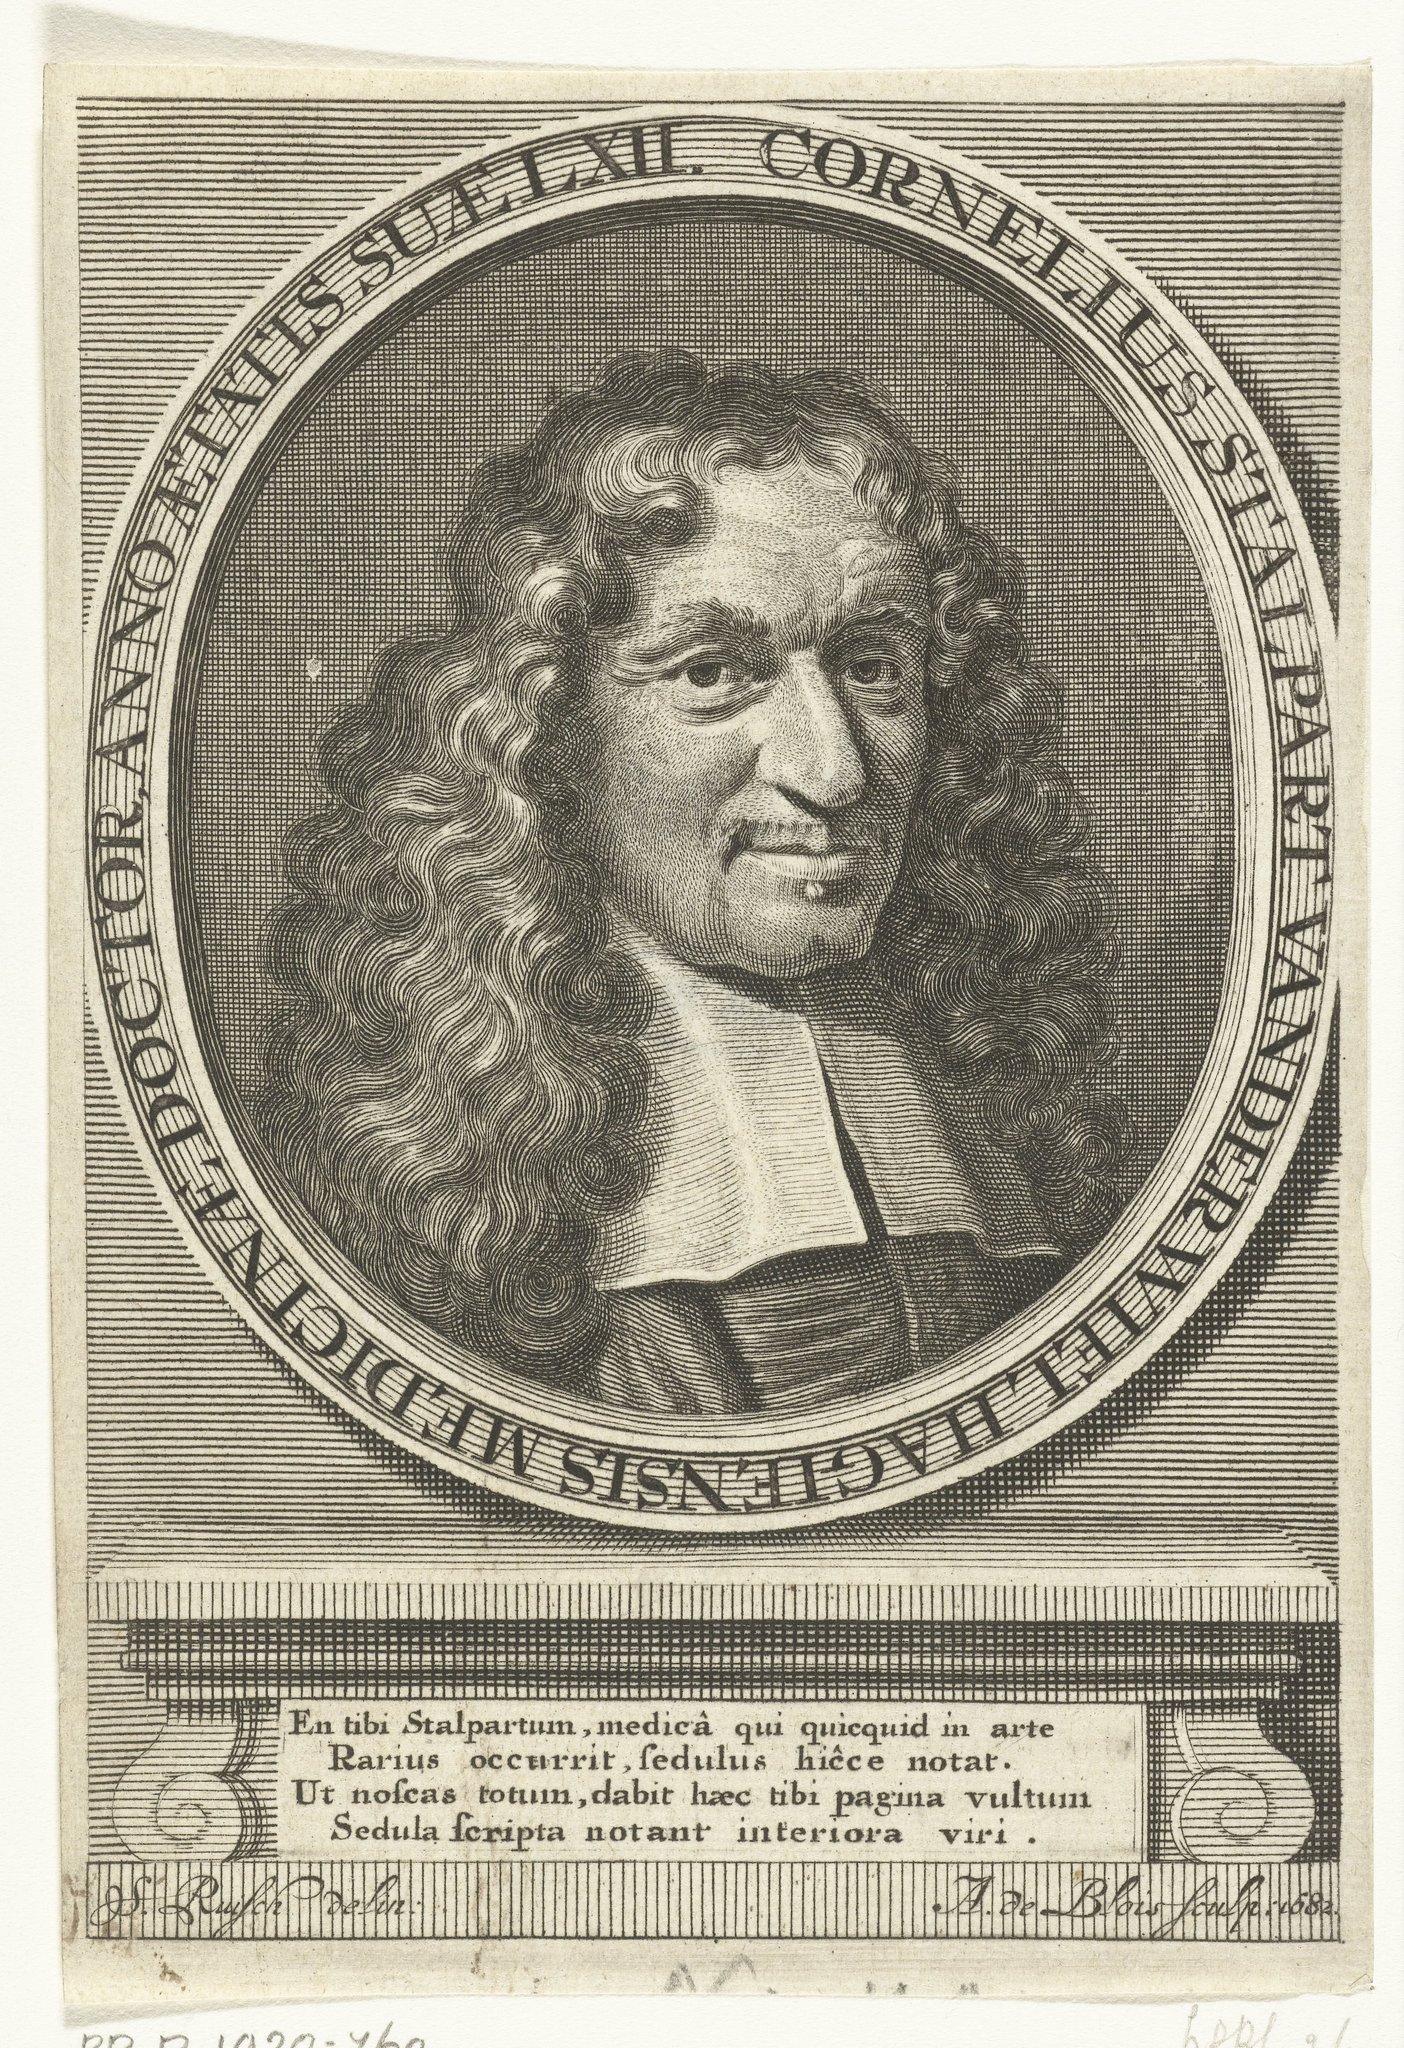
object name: print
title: Cornelius Stalpart van der Wiel Hagiensis medicinae doctor anno aetatis suae LXII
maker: abraham de blois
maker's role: print maker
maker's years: 1679-1717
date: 1682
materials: paper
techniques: engraving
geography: amsterdam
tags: the hague, physician, doctor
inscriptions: collector's mark: Lugt 2228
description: Portret van de Haagse doctor Cornelis Stalpart vander Wiel op 62-jarige leeftijd in ovale omlijsting met Latijns vers in vier regels op console.